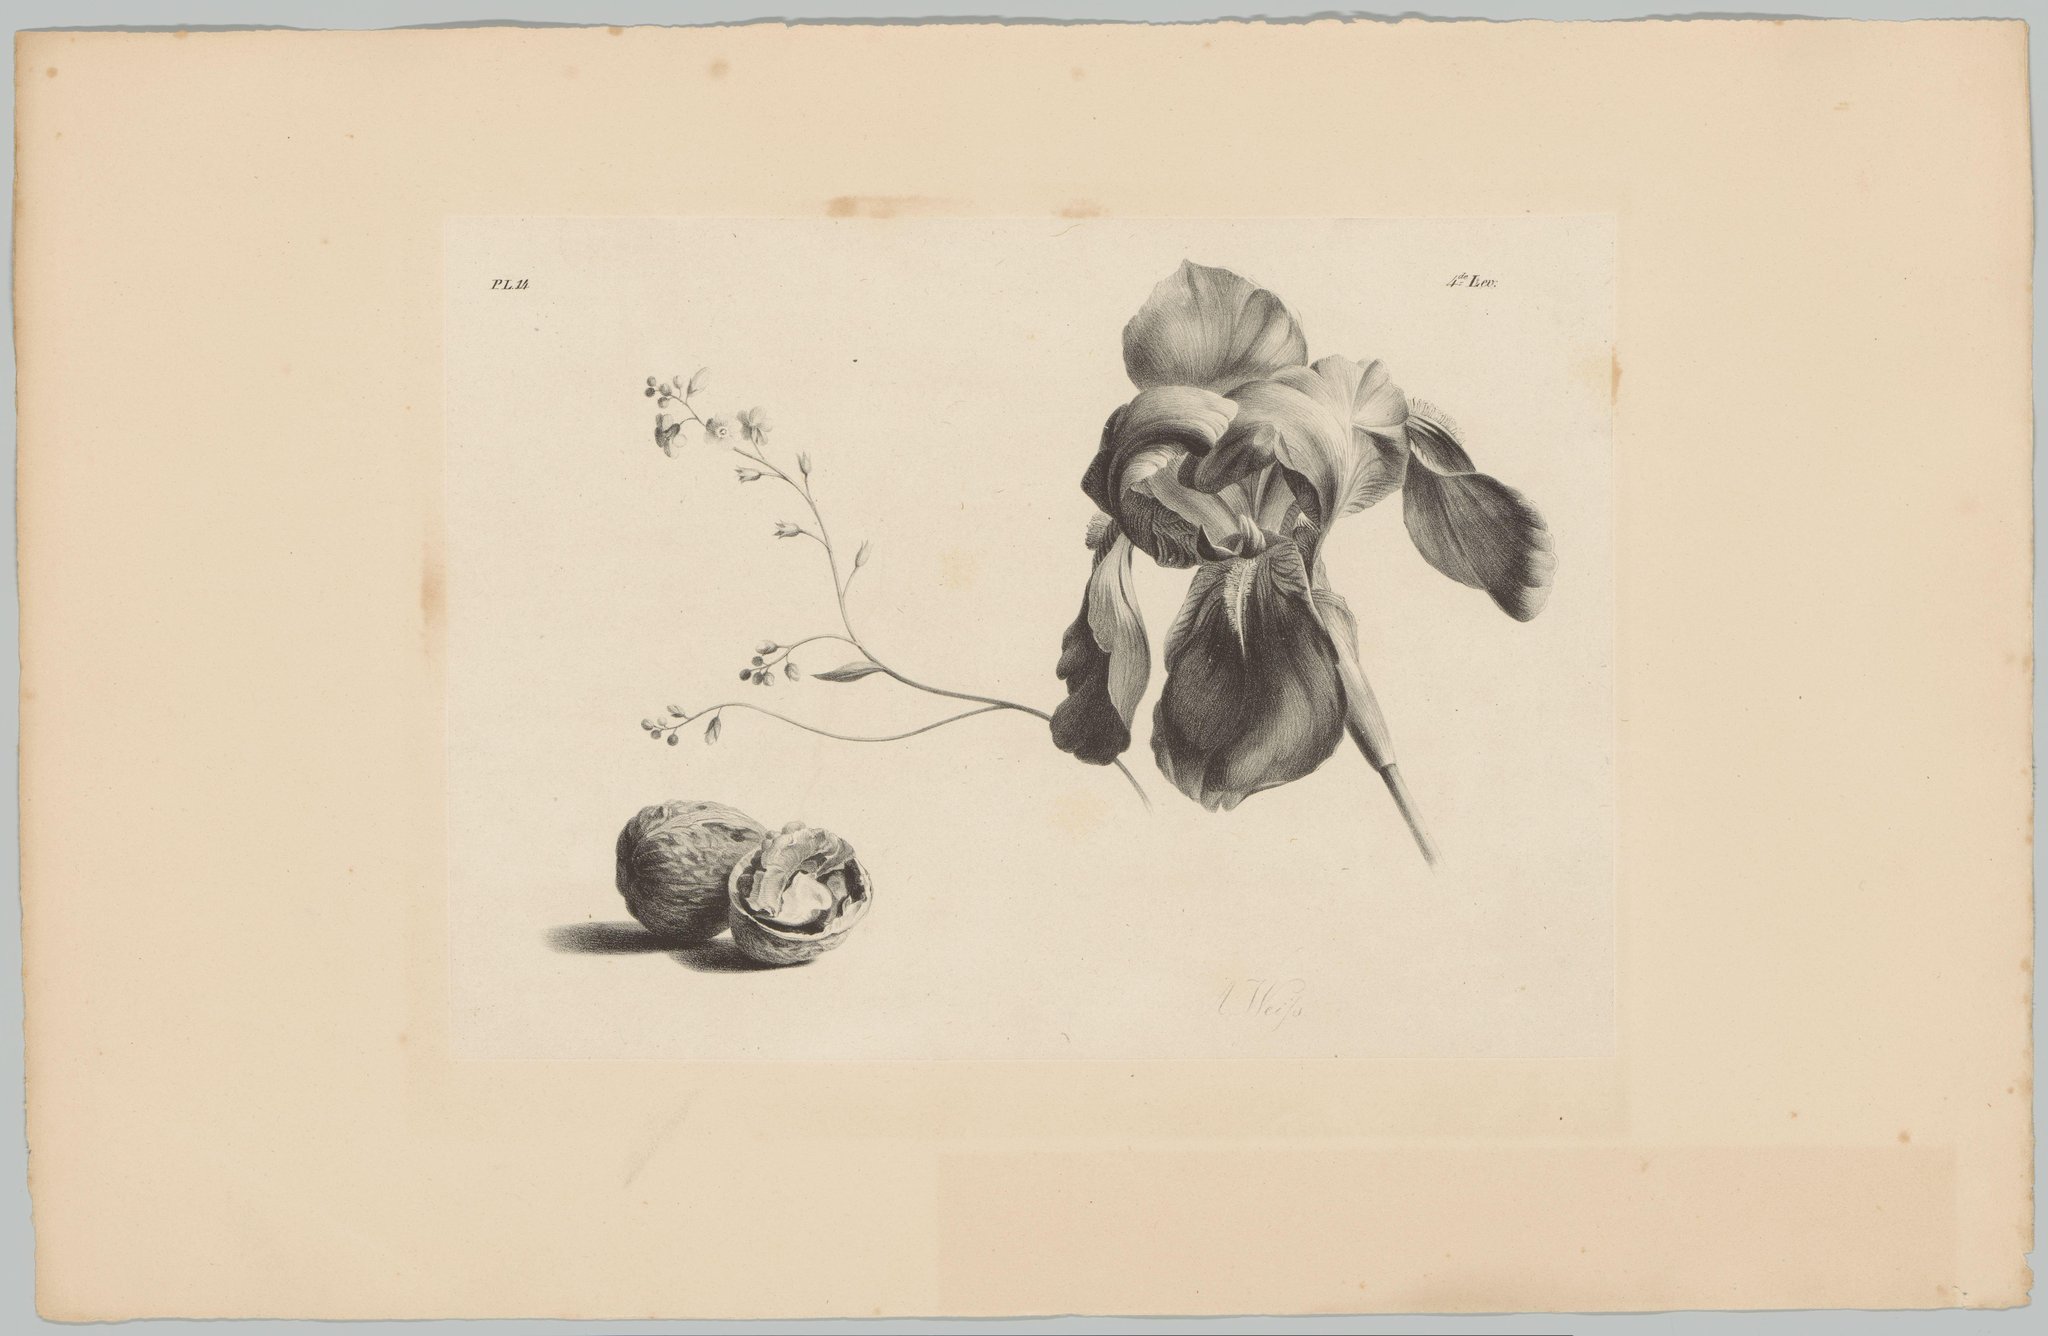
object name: print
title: Amaryllis en walnoten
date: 1820-1833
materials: paper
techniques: lithograph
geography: amsterdam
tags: flowers, fruits: walnut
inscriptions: collector's mark: Lugt 2228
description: Rechts boven genummerd 4de Lev. Onderdeel van een omslag met in totaal zevenenzeventig lithografieën van bloemen en fruit.